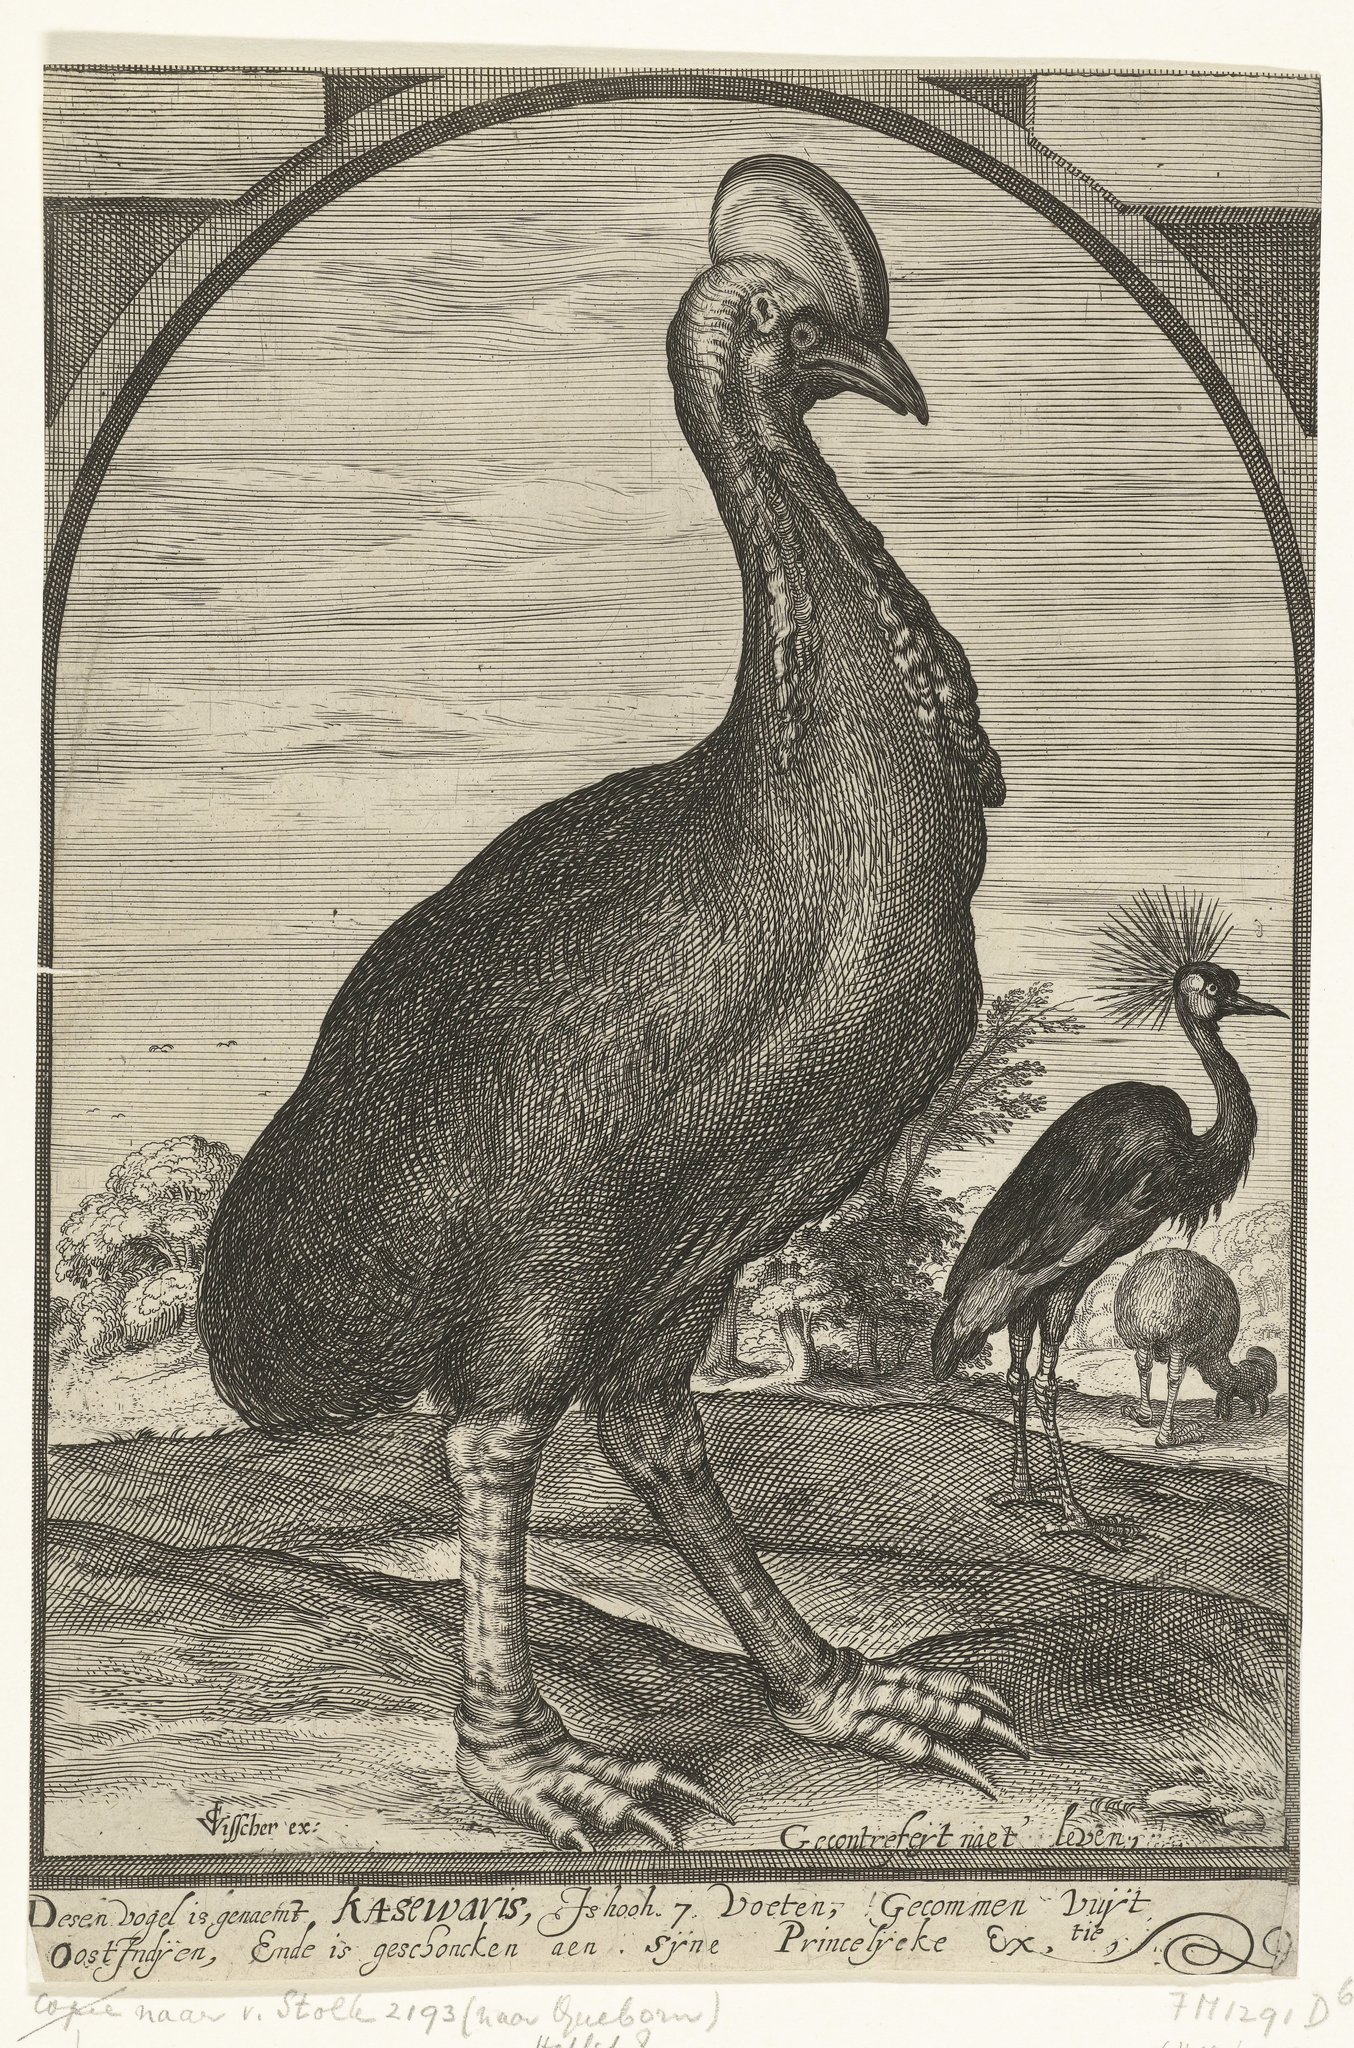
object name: print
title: Casuaris, meegebracht door Willem Jacobsz. uit Oost-Indië en geschonken aan prins Maurits, 1614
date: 1614-1615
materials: paper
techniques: engraving, etching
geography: amsterdam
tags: the hague, maurice (prince of orange), walker and runner birds: cassowary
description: Kasuaris, meegebracht door schipper Willem Jacobsz. uit Oost-Indië en geschonken aan prins Maurits voor zijn menagerie te Rijswijk, 14 augustus 1614. De vogel afgebeeld staand in een landschap, op de achtergrond een Afrikaanse kroonkraanvogel en een bukkende kasuaris. Met onderschrift van 2 regels in het Nederlands.